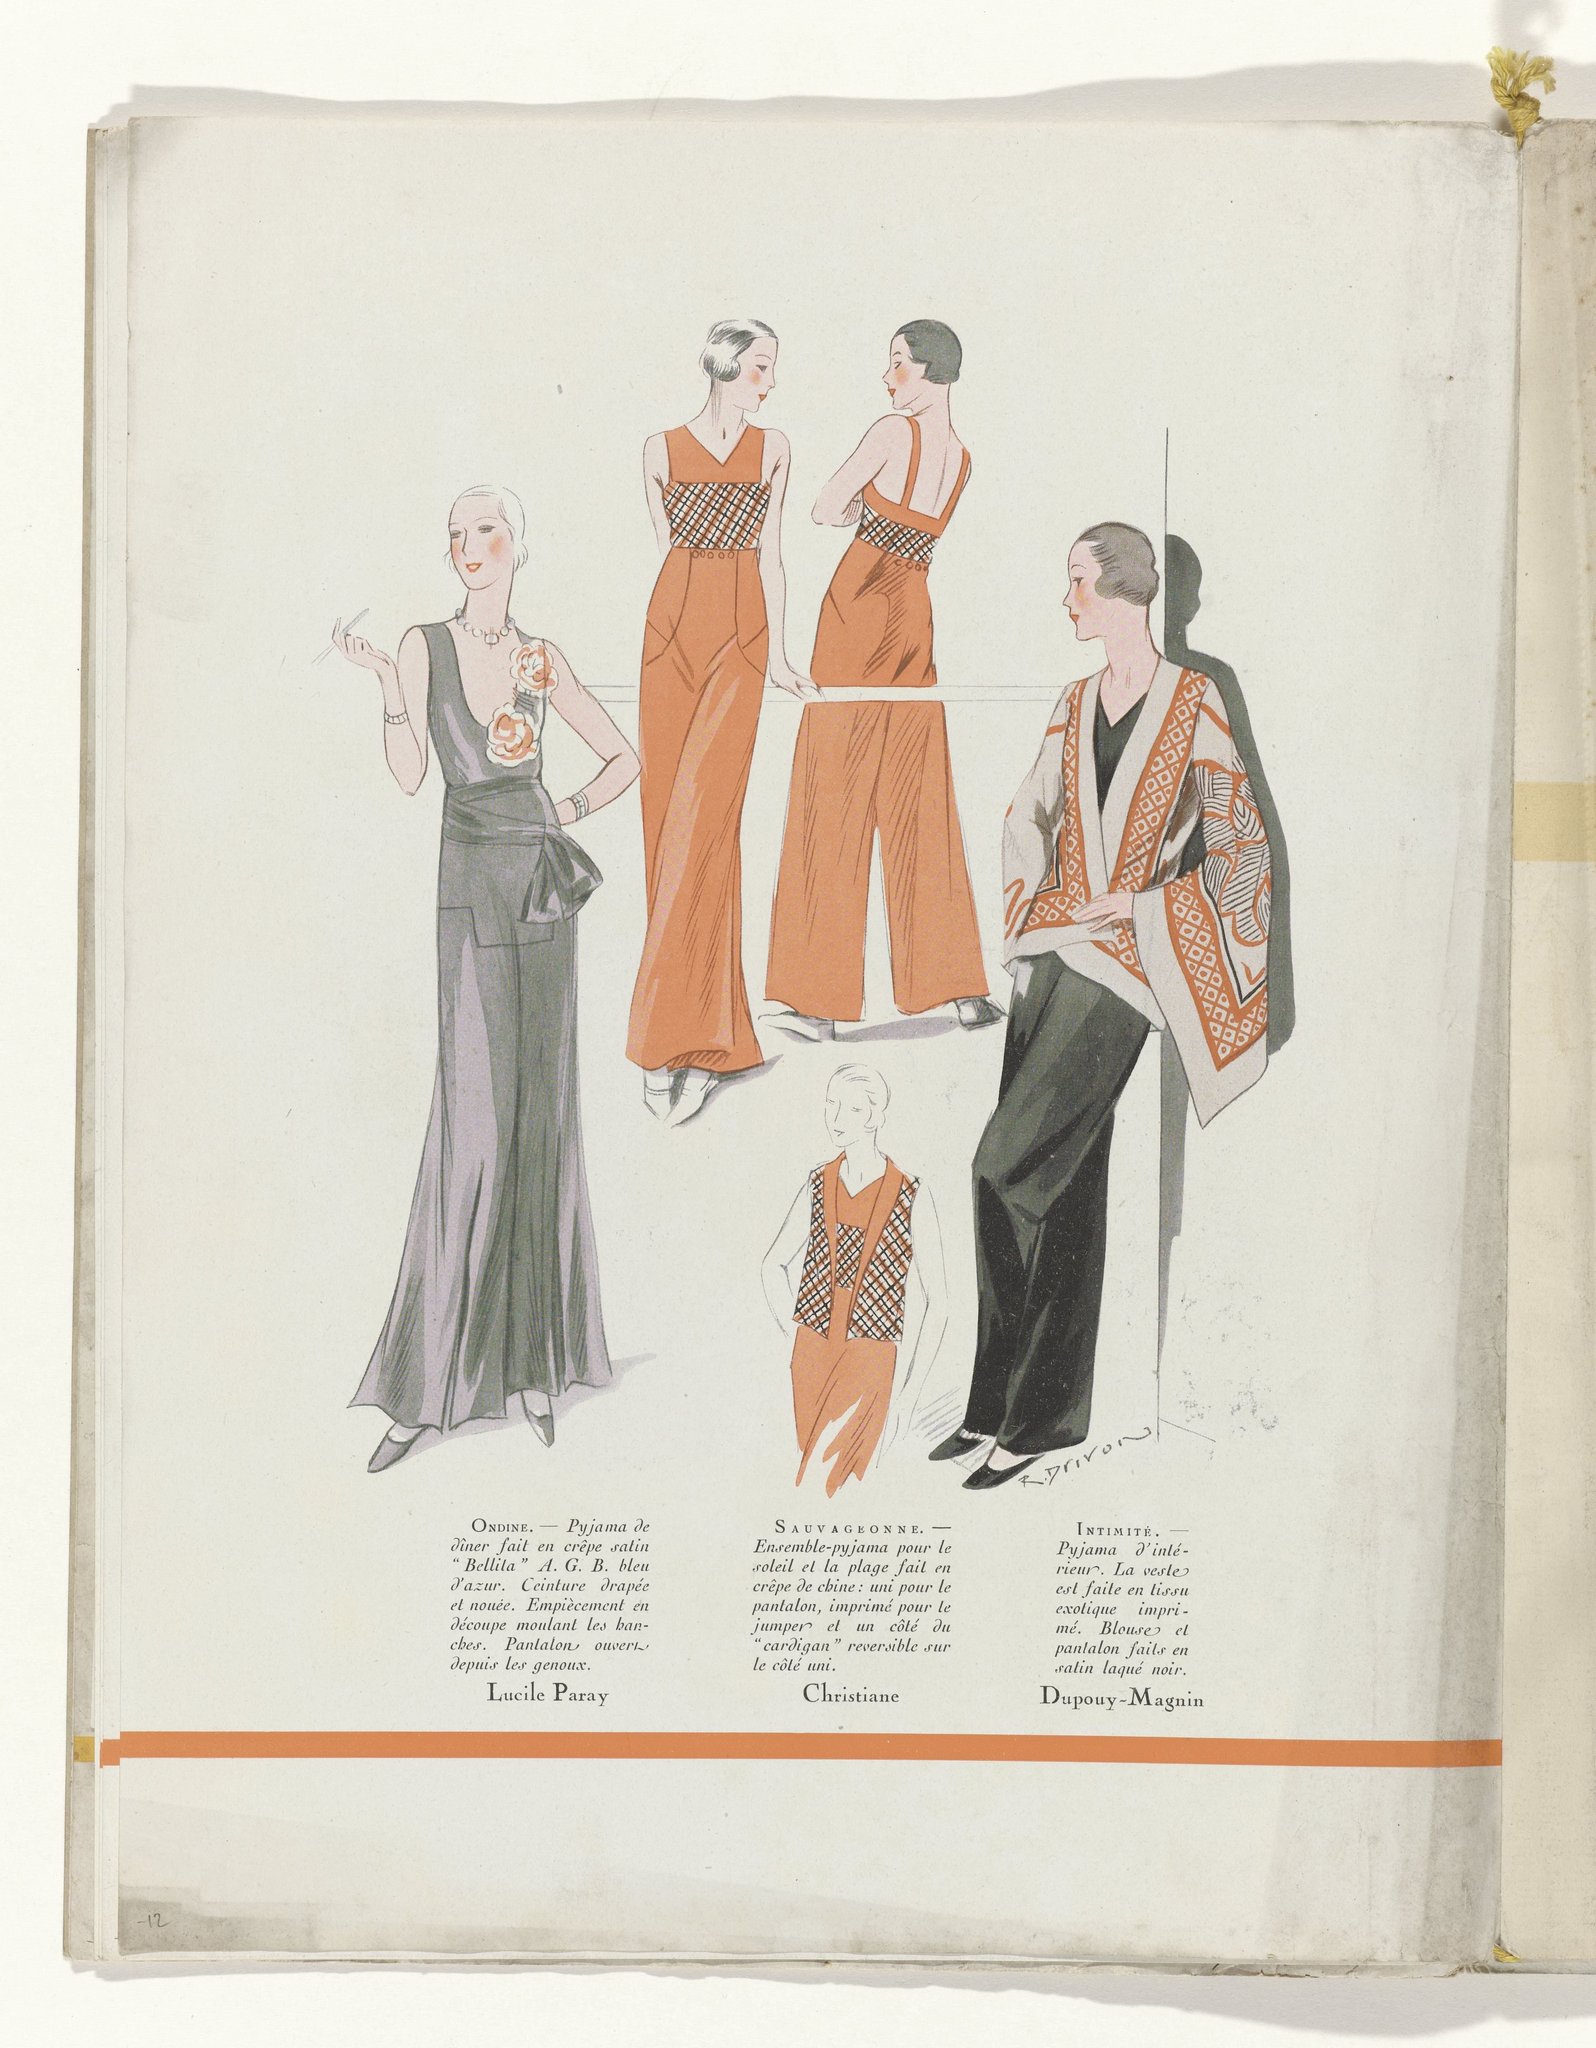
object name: fashion print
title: Art - Goût - Beauté, Feuillets de l' élégance féminine, Mai 1931, No. 129, 11e Année, p. 12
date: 1931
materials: paper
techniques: printing, photography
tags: clothing for the upper part of the body: blouse (+ women's clothes), clothing for the upper part of the body (vest) (+ women's clothes), trousers, breeches, etc. (pantalon) (+ women's clothes), fashion plates, belt, girdle, waistband (+ women's clothes)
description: Vijf vrouwen, van wie er drie dezelfde strandpyjama dragen. Links: 'pyjama de dîner' van blauwe 'crêpe satin "Bellita" A.G.B., van Lucile Paray. Midden: 'ensemble-pyiama' voor op het strand, gemaakt van crêpe de chine, van Christiane. Rechts: 'pyjama d'intérieur', bestaande uit een jasje, blouse en lange broek, van Dupouy-Magnin. Pagina uit het modetijdschrift Art-Goût-Beauté (1920-1933).